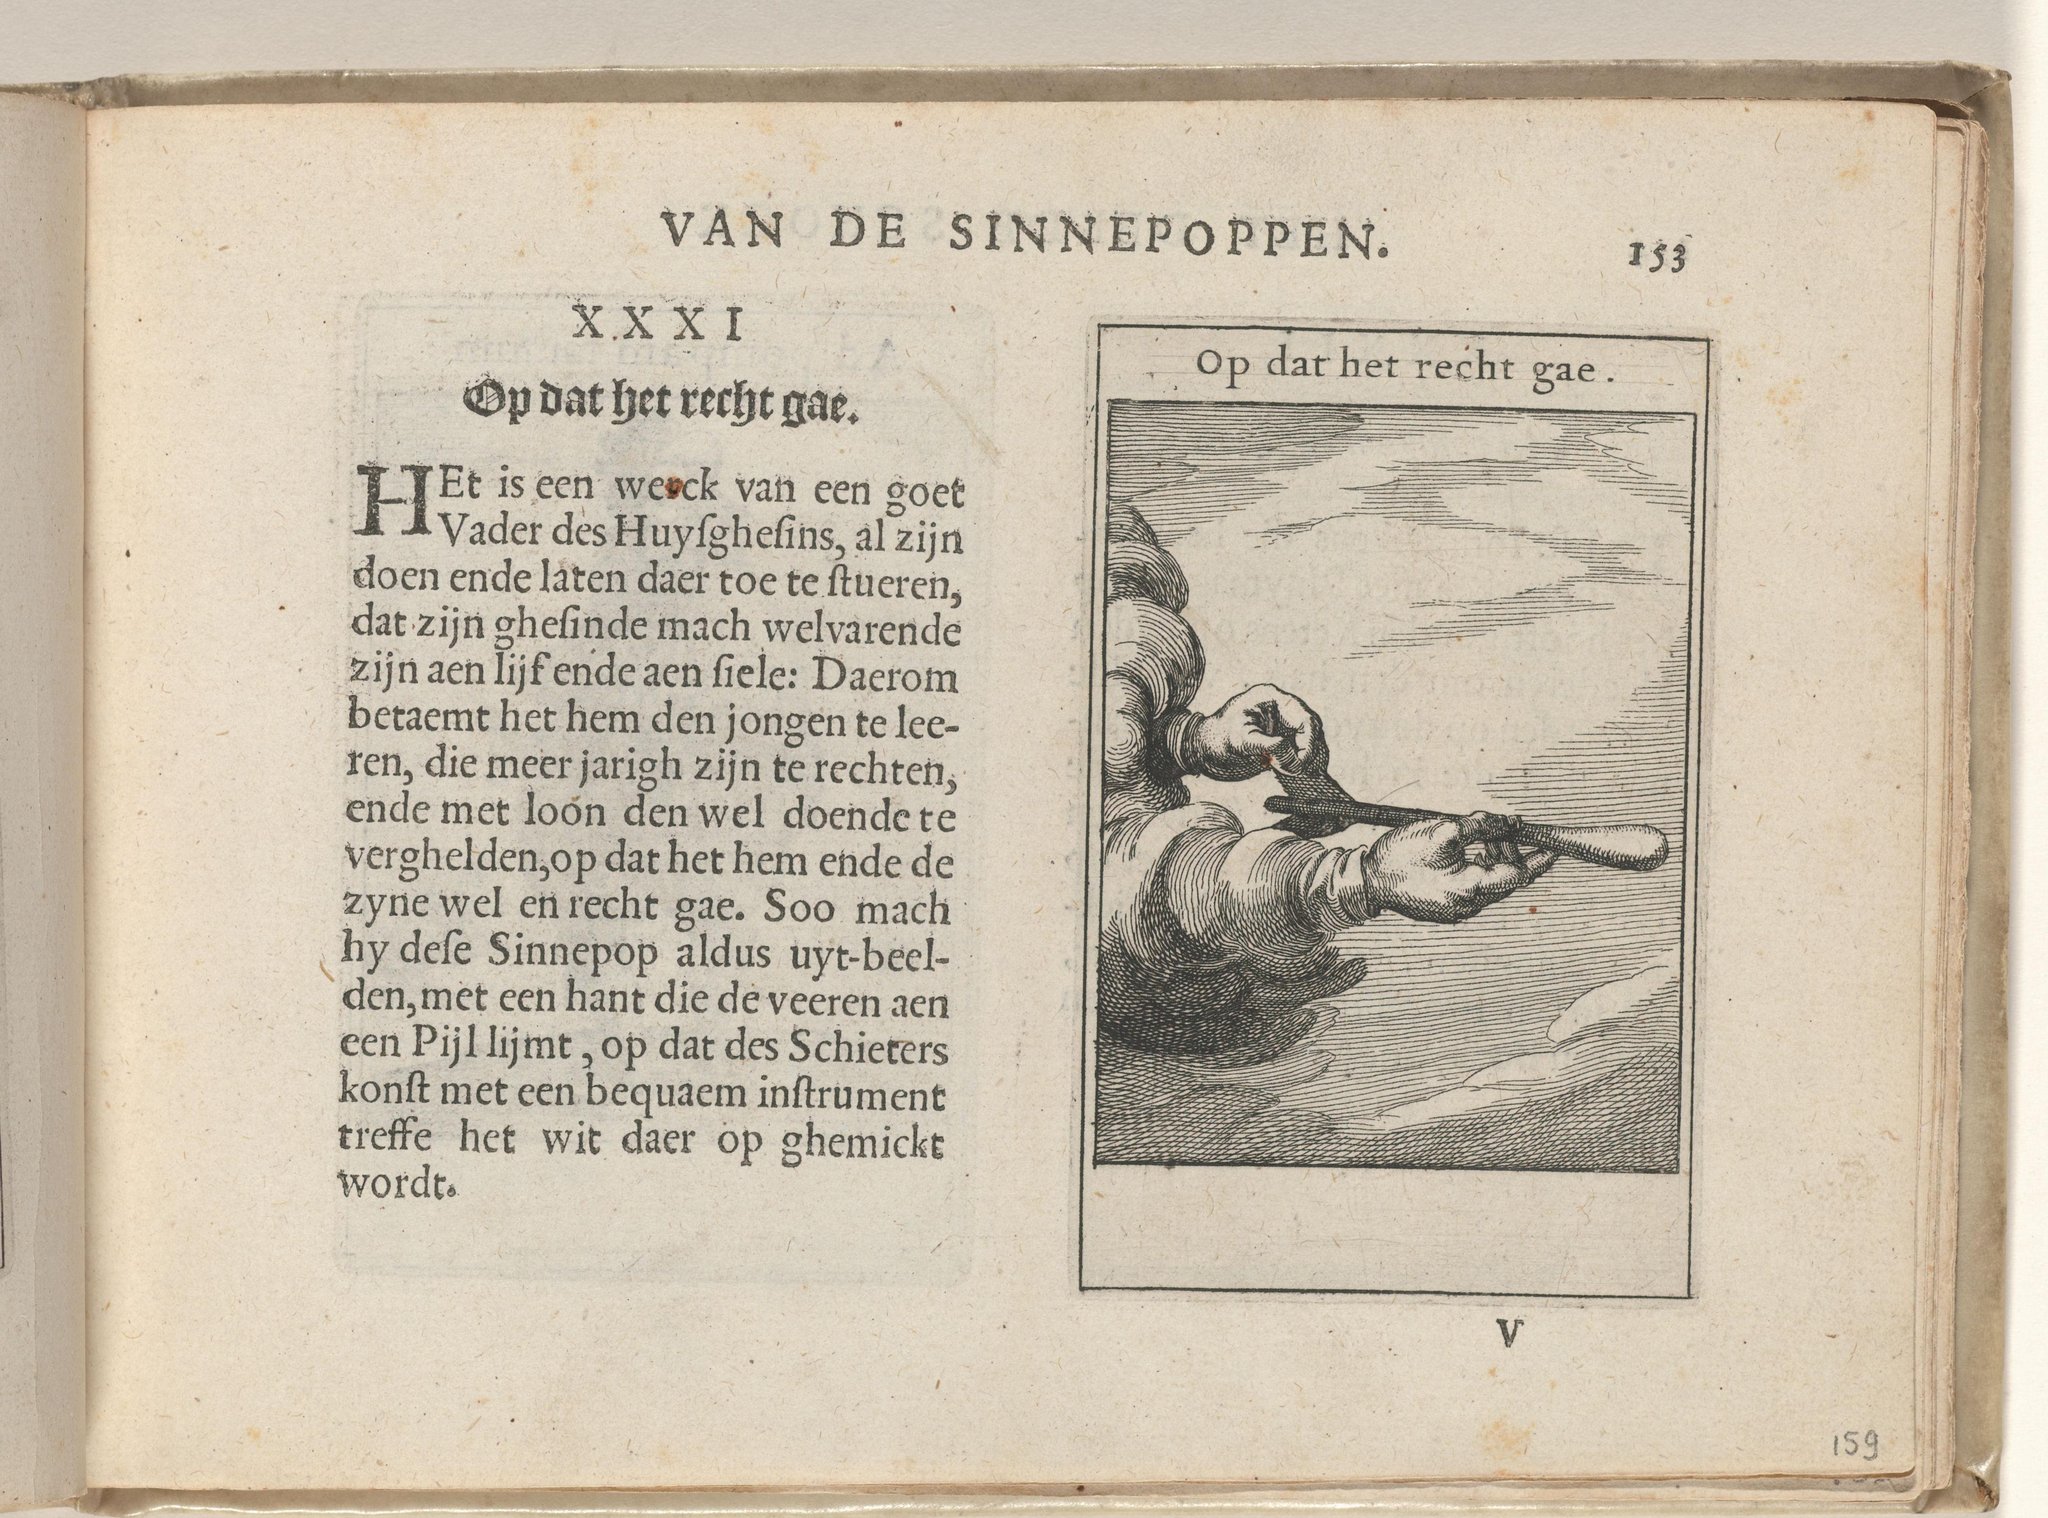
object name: print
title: XXXI Op dat het recht gae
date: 1614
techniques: engraving, printing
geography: the hague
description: XXXI Op dat het recht gae. Derde schok. Onderdeel van 'Sinnepoppen', R. Visscher, 1614.